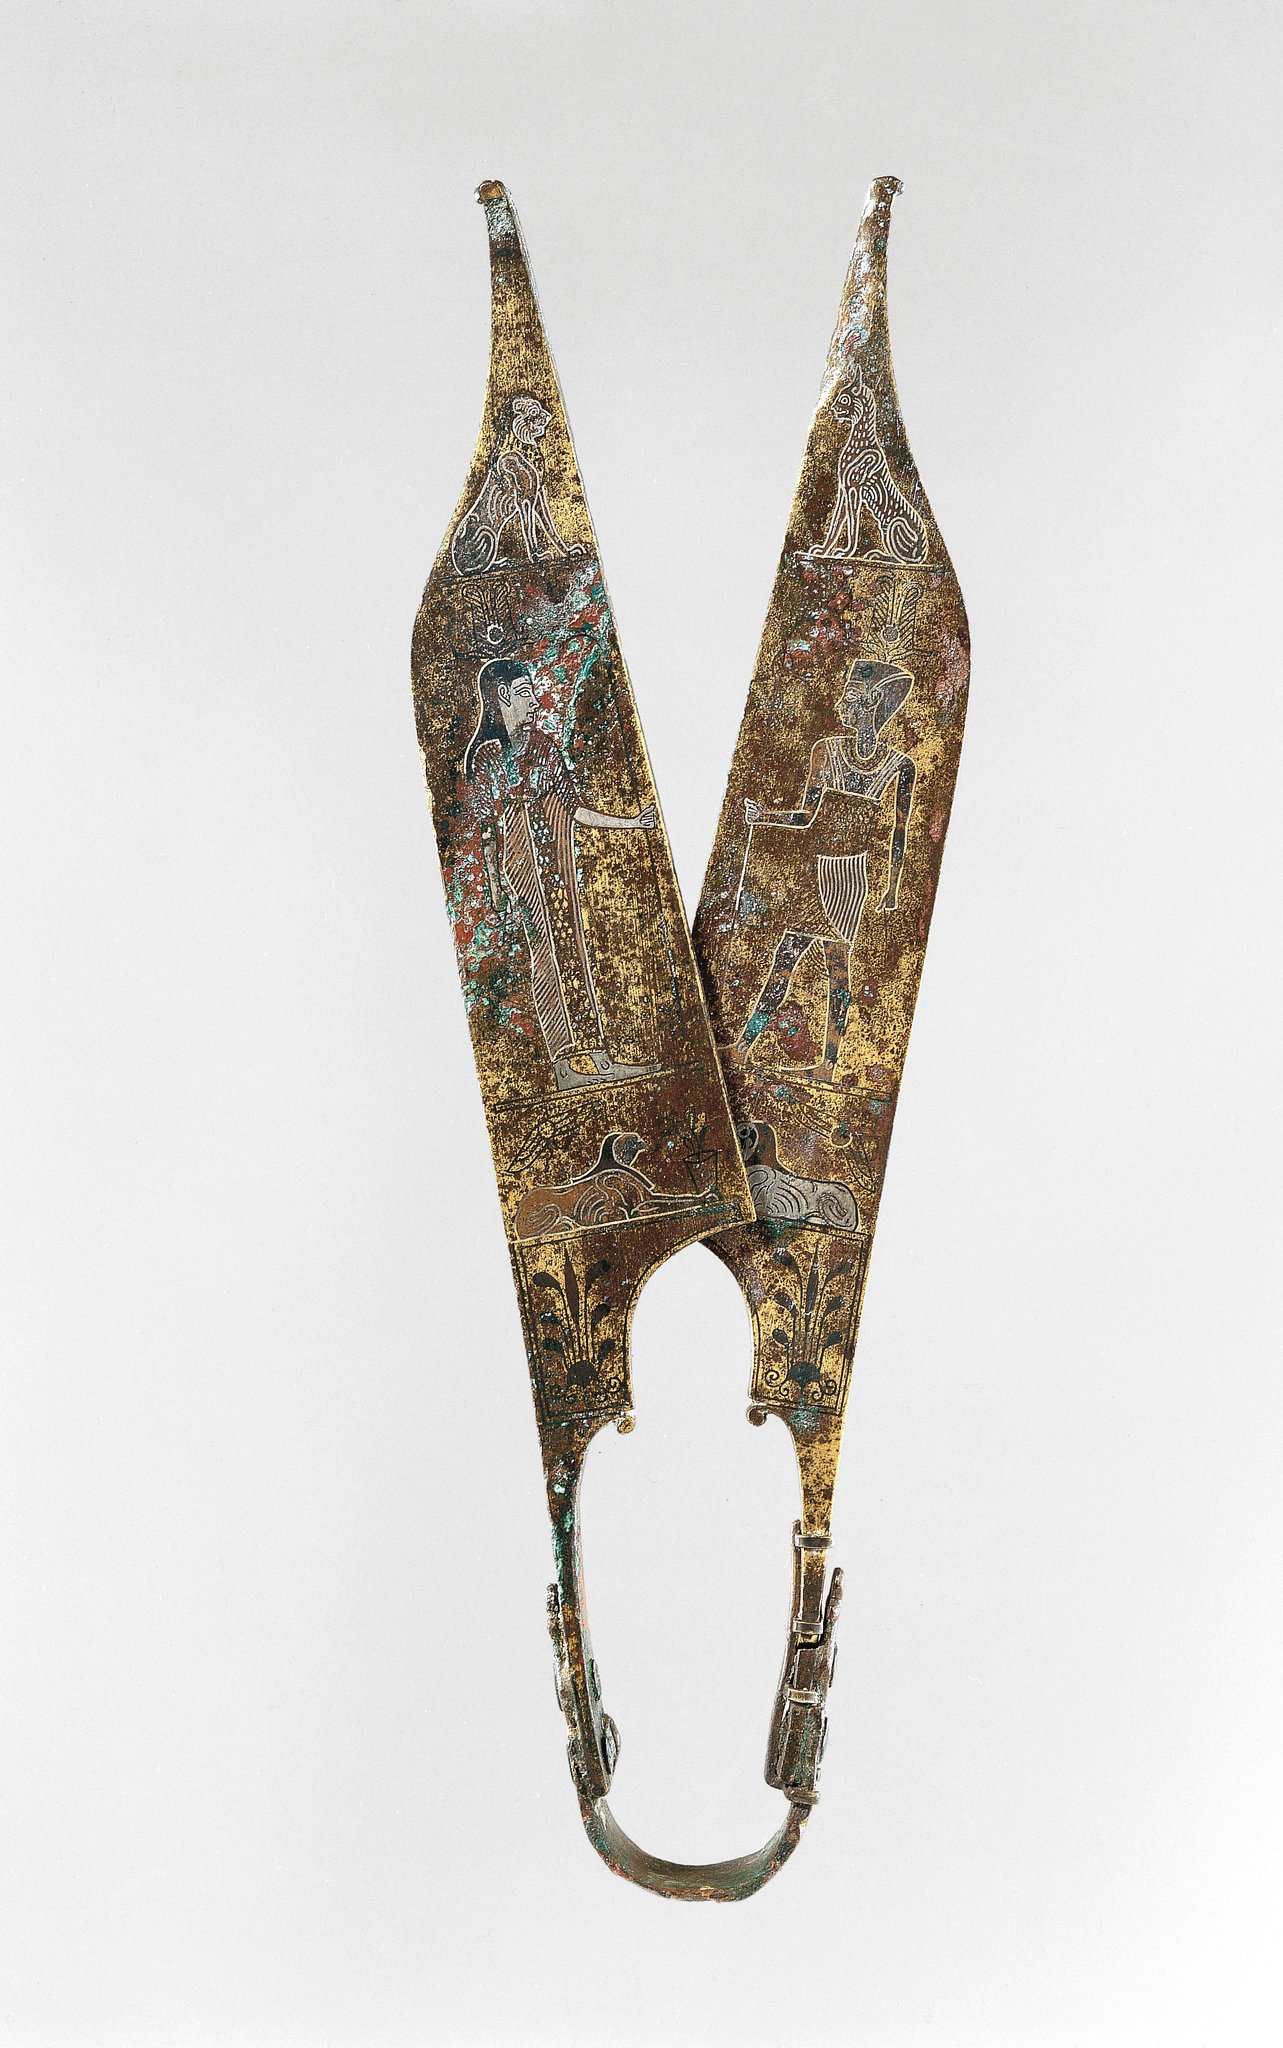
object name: scissors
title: Shears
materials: bronze, copper, copper alloy, silver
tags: scissors